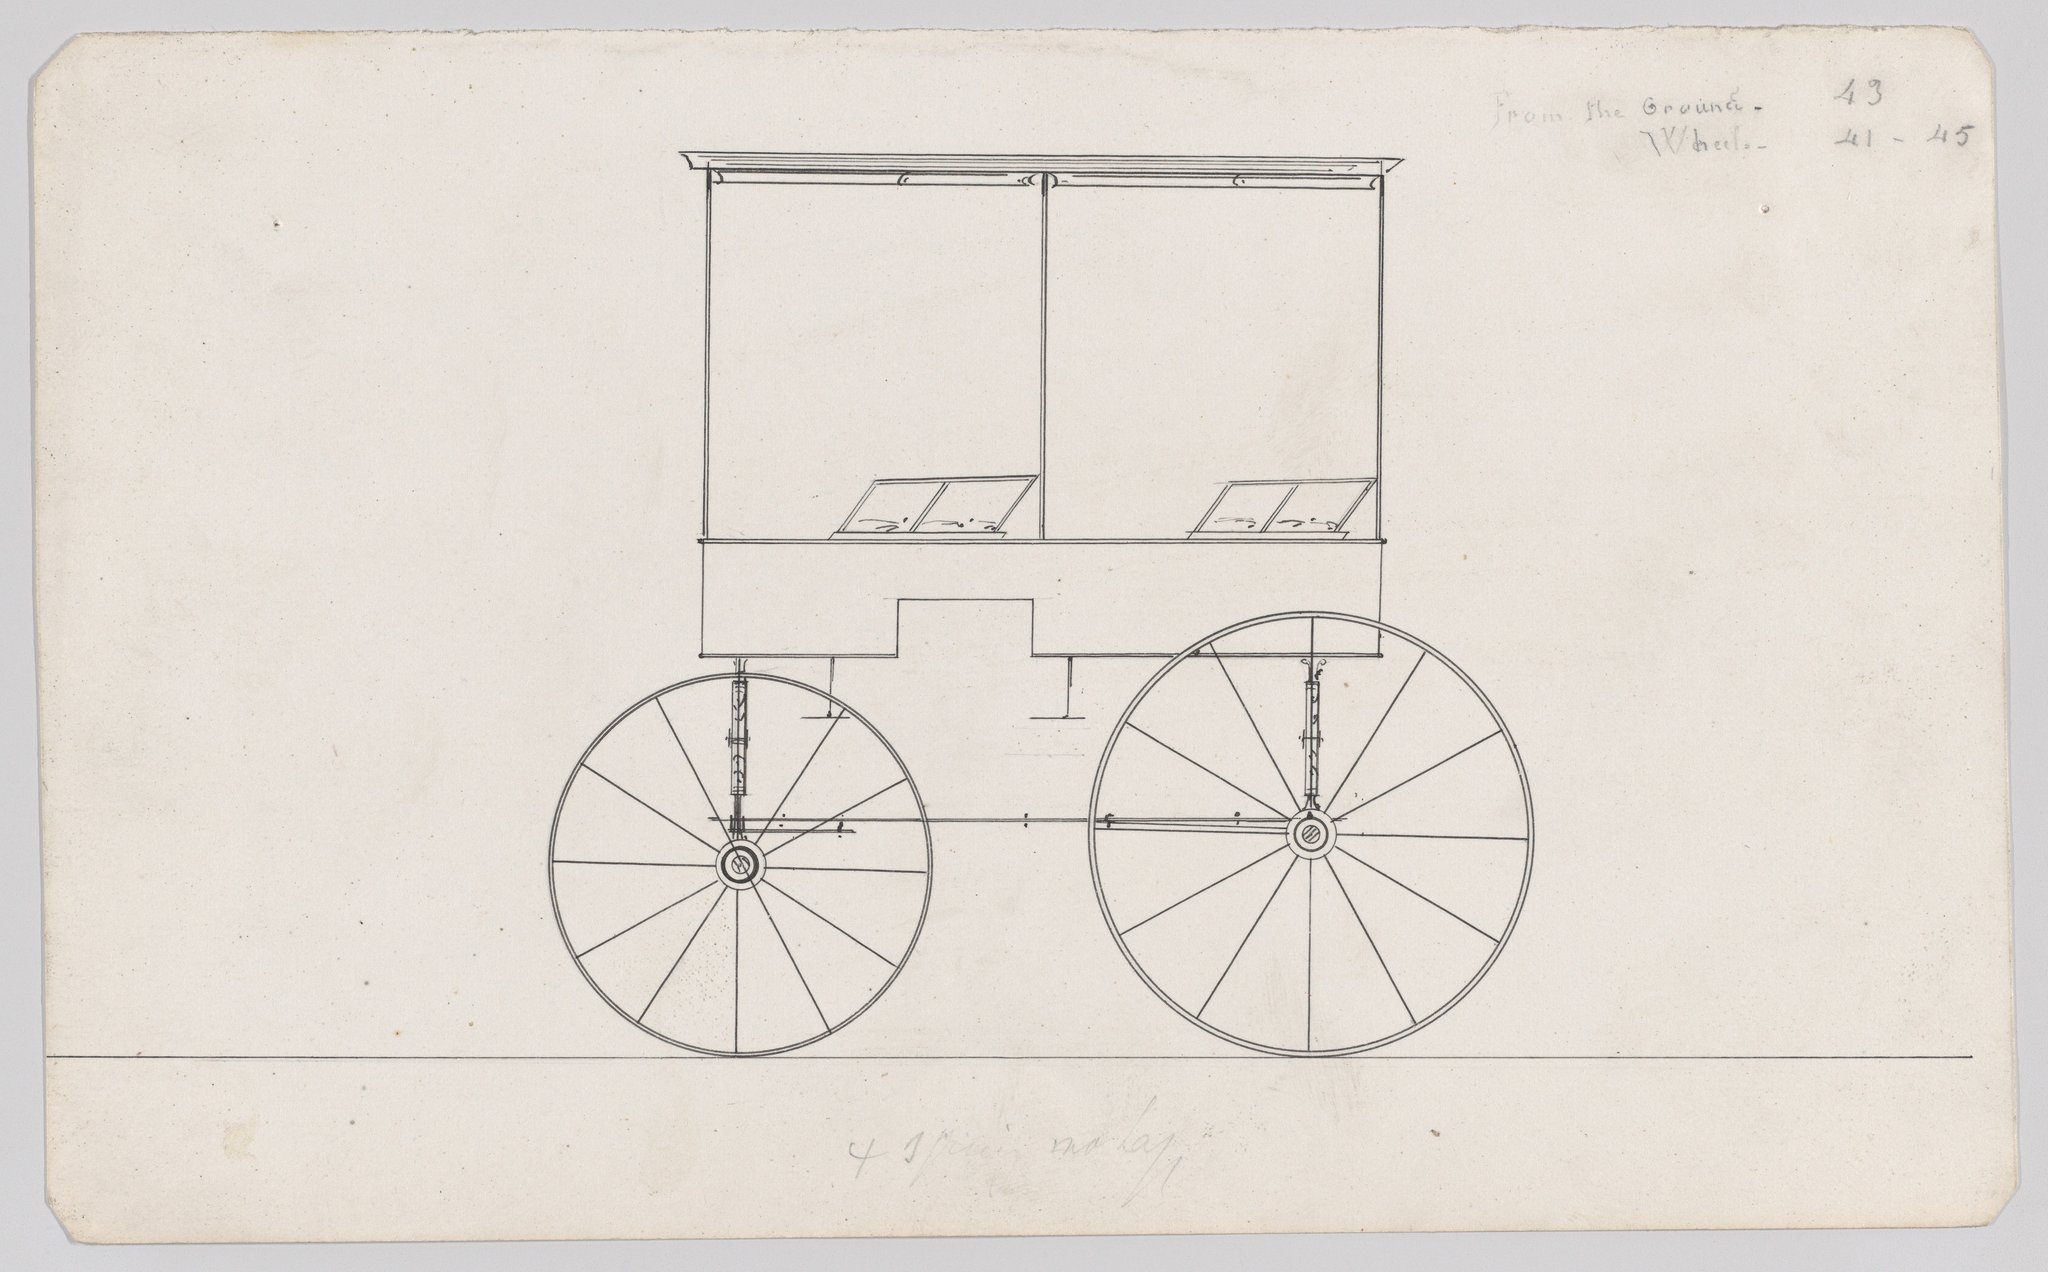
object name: drawing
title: Design for Canopy Top Wagon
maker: brewster & co.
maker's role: manufacturer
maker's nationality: american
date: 1850-1870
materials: ink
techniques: pen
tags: carriages